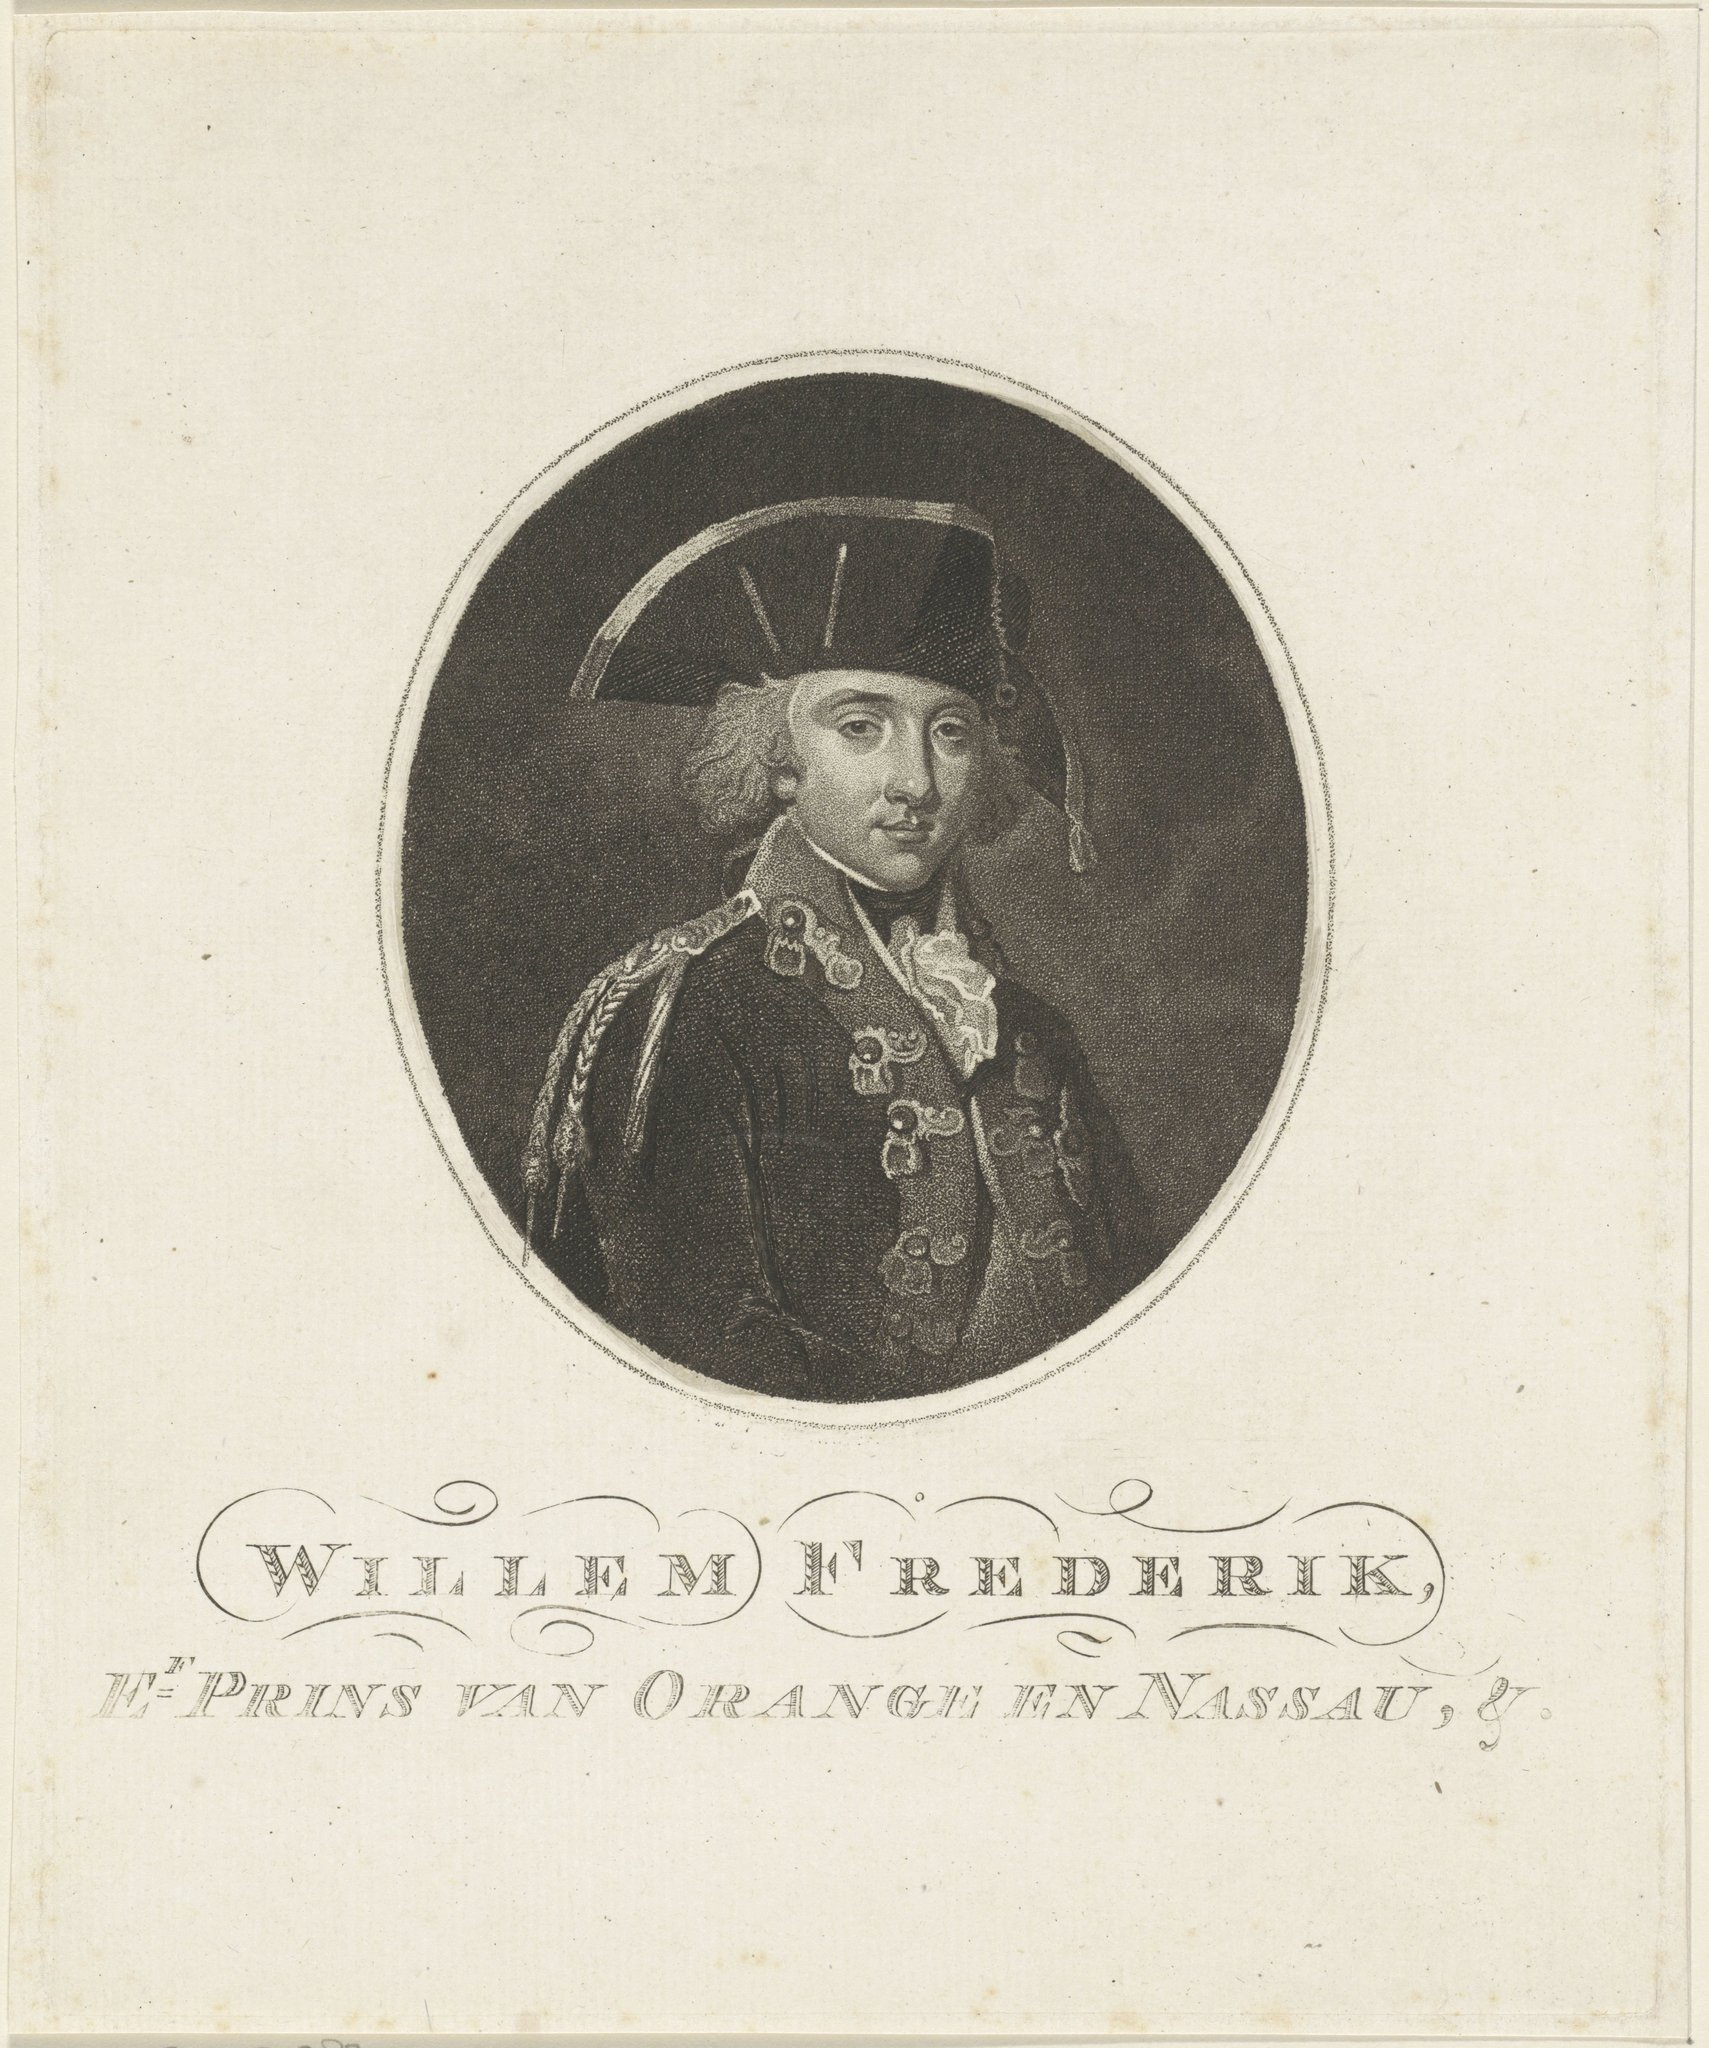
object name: print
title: Portret van Frederik, prins van Oranje-Nassau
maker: Anonymous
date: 1790-1849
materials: paper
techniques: engraving, etching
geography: low countries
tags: the hague, willem george frederik (prins van oranje-nassau)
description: De hier vermelde titel verwijst naar de hoogst verkregen titel van de geportretteerde, niet per se naar de titel die de geportretteerde op deze voorstelling draagt.